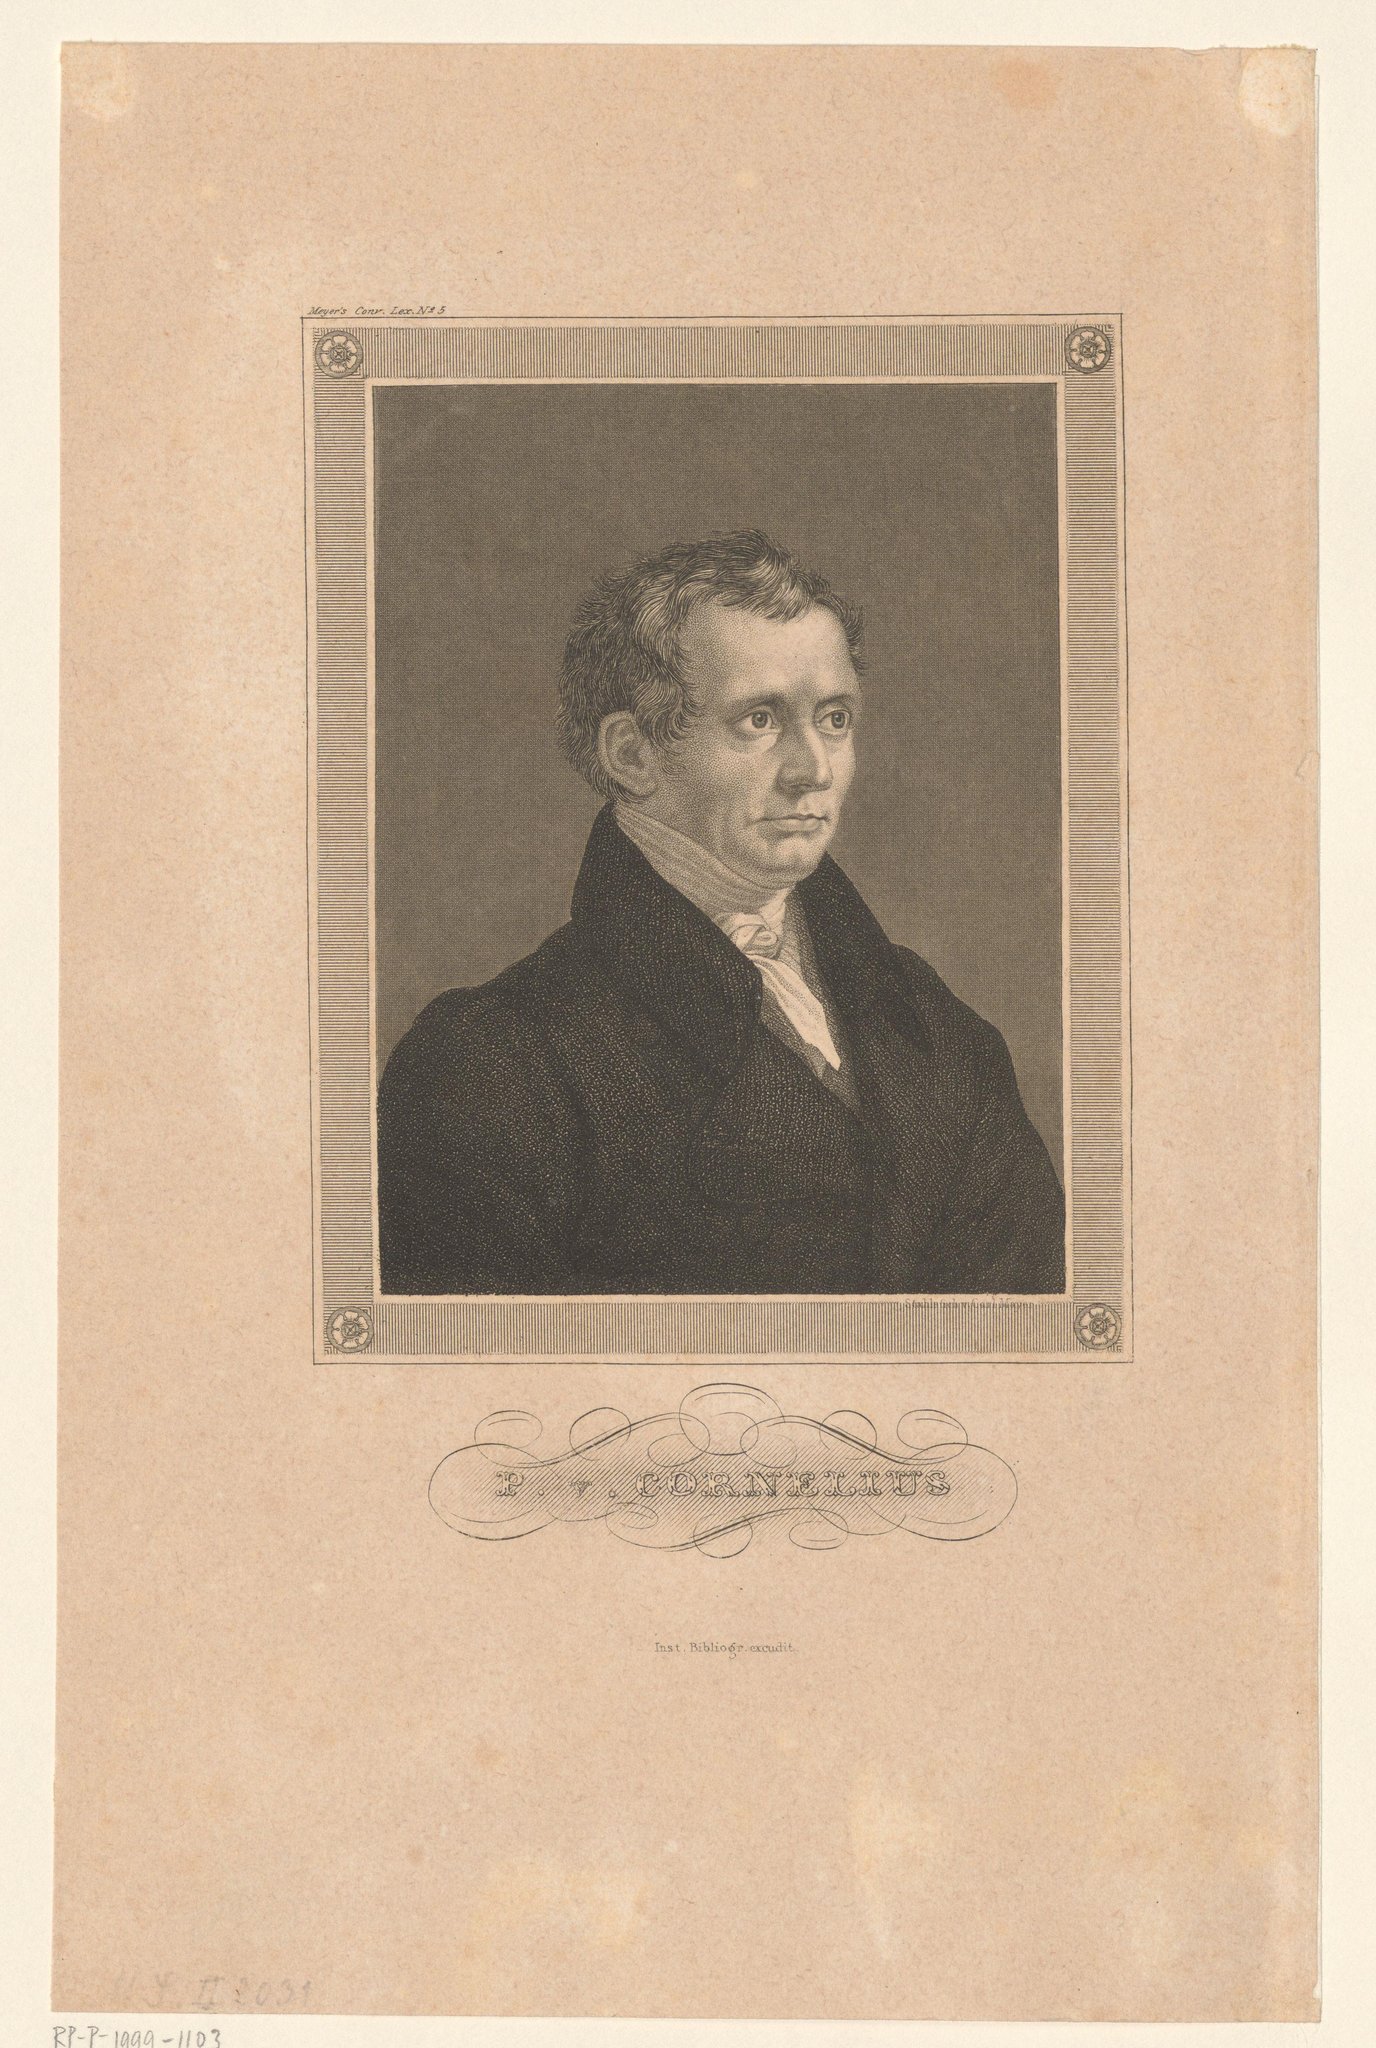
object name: print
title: Portret van Peter von Cornelius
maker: carl mayer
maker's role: print maker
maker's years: 1798-1868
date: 1839-1855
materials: paper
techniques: engraving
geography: hildburghausen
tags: berlin, peter von cornelius, historical persons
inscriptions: collector's mark: Lugt 2228, collector's mark: Lugt 4100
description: Prent uit: Meyer, Joseph. Conversations-Lexikon für die gebildeten Stände. Hildburghausen: Bibliographisches Institut, 1839-1855.